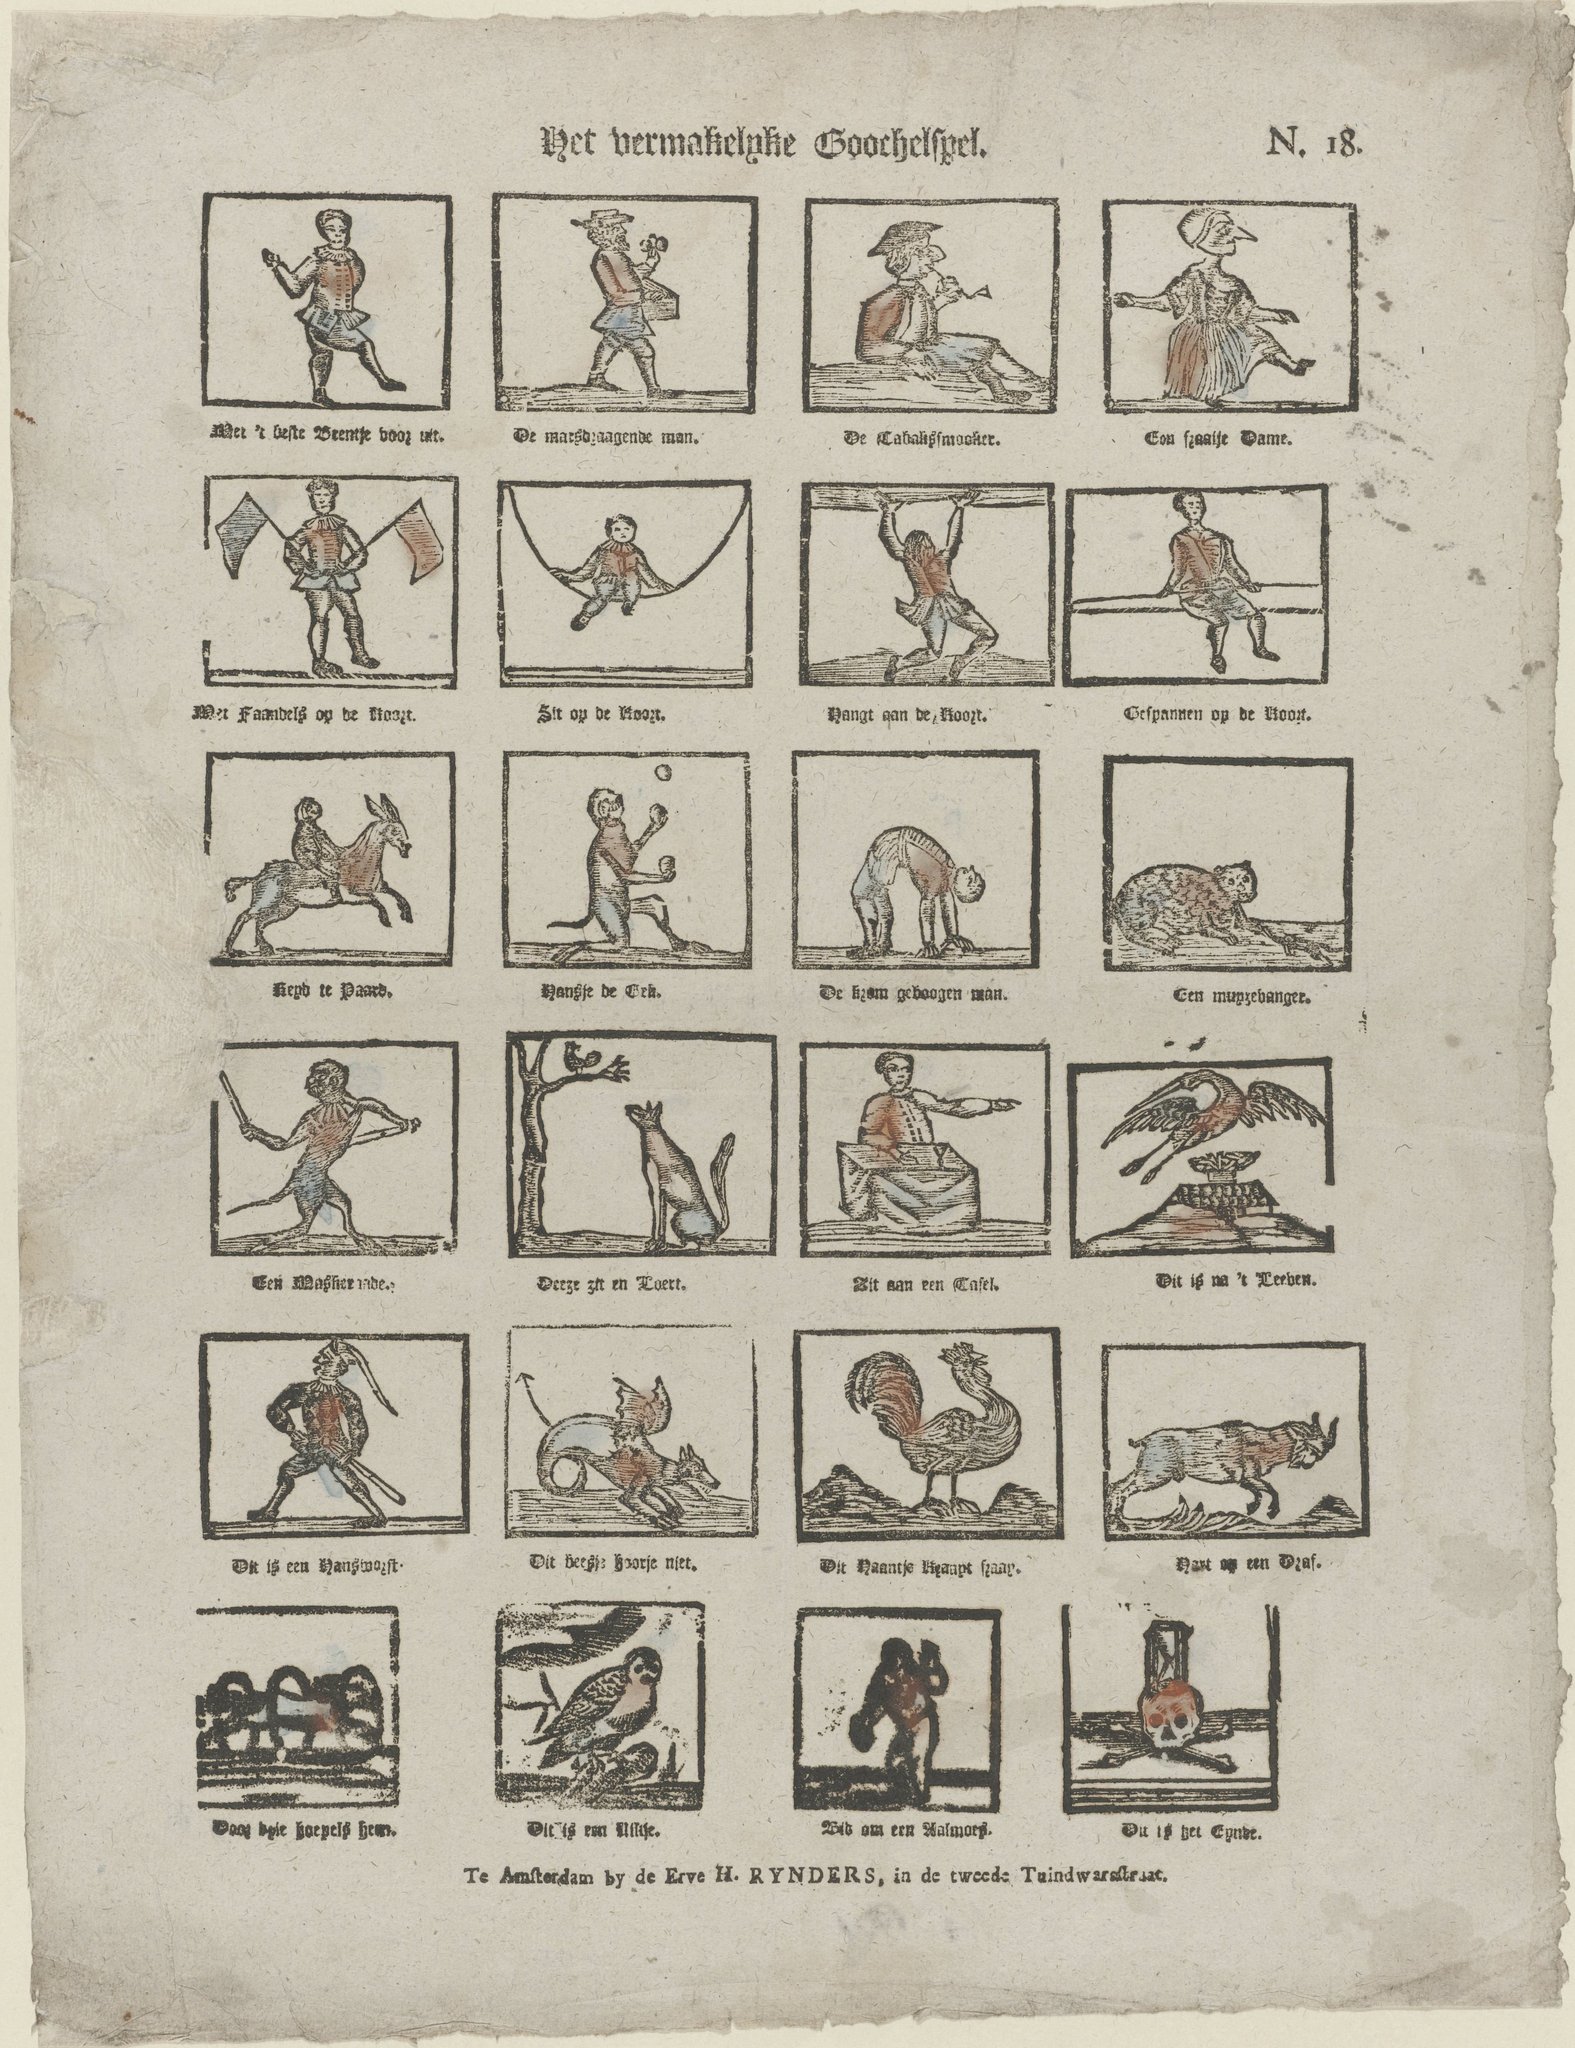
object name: print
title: Het vermakelyke goochelspel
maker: Anonymous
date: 1831-1854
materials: paper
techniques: colour, letterpress printing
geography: netherlands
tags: animals, human types, caricatures (human types)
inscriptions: collector's mark: Lugt 2760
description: Blad met 24 voorstellingen van verschillende figuren, dieren en een doodshoofd. Onder elke voorstelling een onderschrift. Genummerd rechtsboven: N. 18.